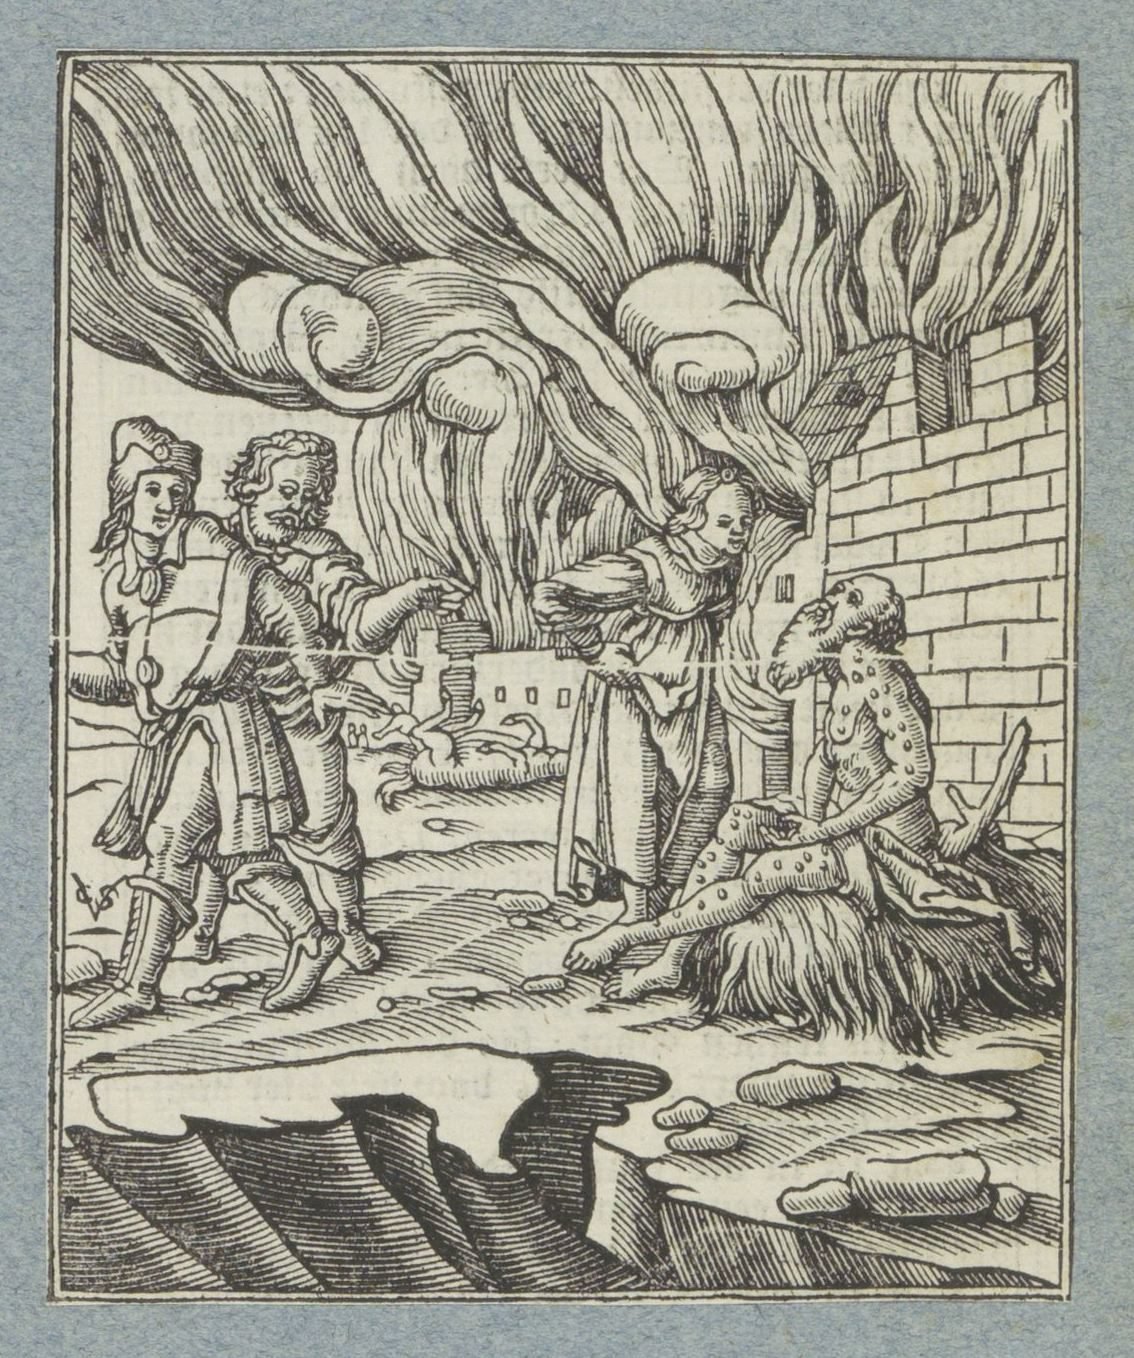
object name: album leaf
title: Verzoeking van Job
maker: pieter jacobsz. paets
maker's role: publisher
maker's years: 1587-1667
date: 1645-1646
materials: paper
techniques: letterpress printing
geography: amsterdam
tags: job on the dunghill with satan (or devils) abusing and tormenting him; job's wife may be present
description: De prent werd gemaakt voor de uitgaven van P.J. Paets uit Amsterdam. Ze komt in ieder geval voor in: Bibels Tresoor ofte der zielen lusthof. Amsterdam, P.J. Paets, 1646. Mogelijk ook in: Historien ende Prophetien. [Amsterdam], P.J. Paets, 1645.